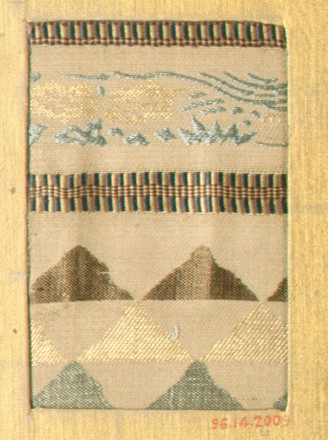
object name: piece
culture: japanese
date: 1701-1900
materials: silk